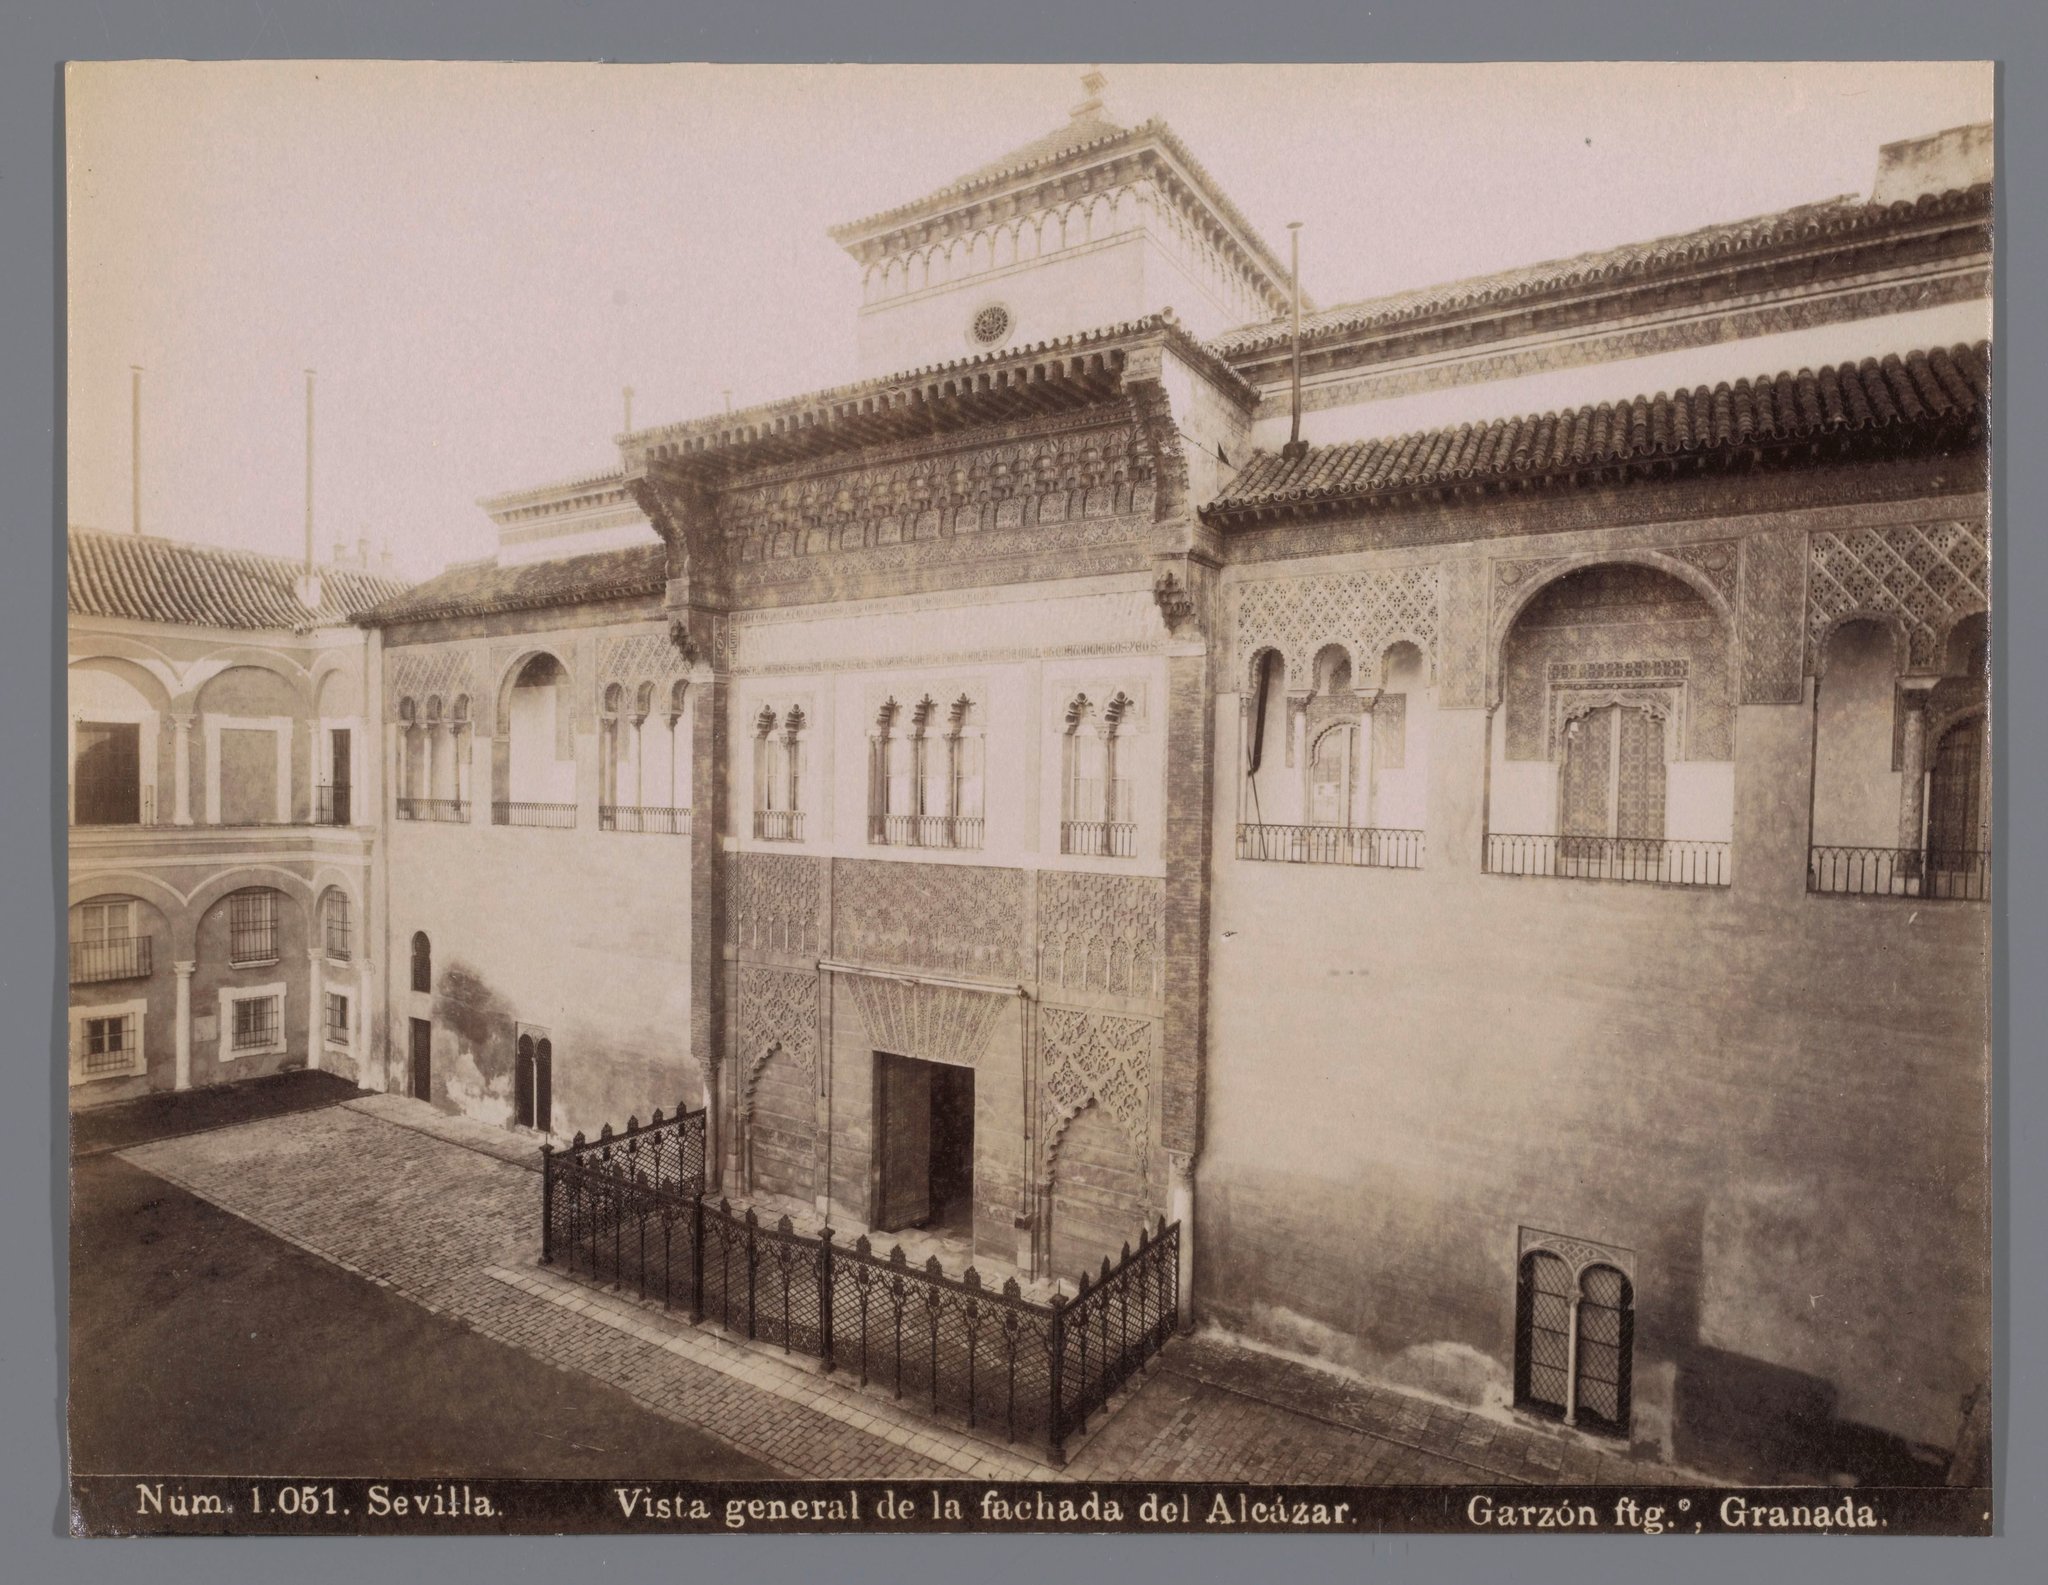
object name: photograph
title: Sevilla, vista general de la fachada del Alcázar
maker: rafael garzón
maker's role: publisher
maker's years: 1863-1923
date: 1880-1900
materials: paper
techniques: albumen print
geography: granada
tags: palace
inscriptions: number: ‘Núm. 1.051.’